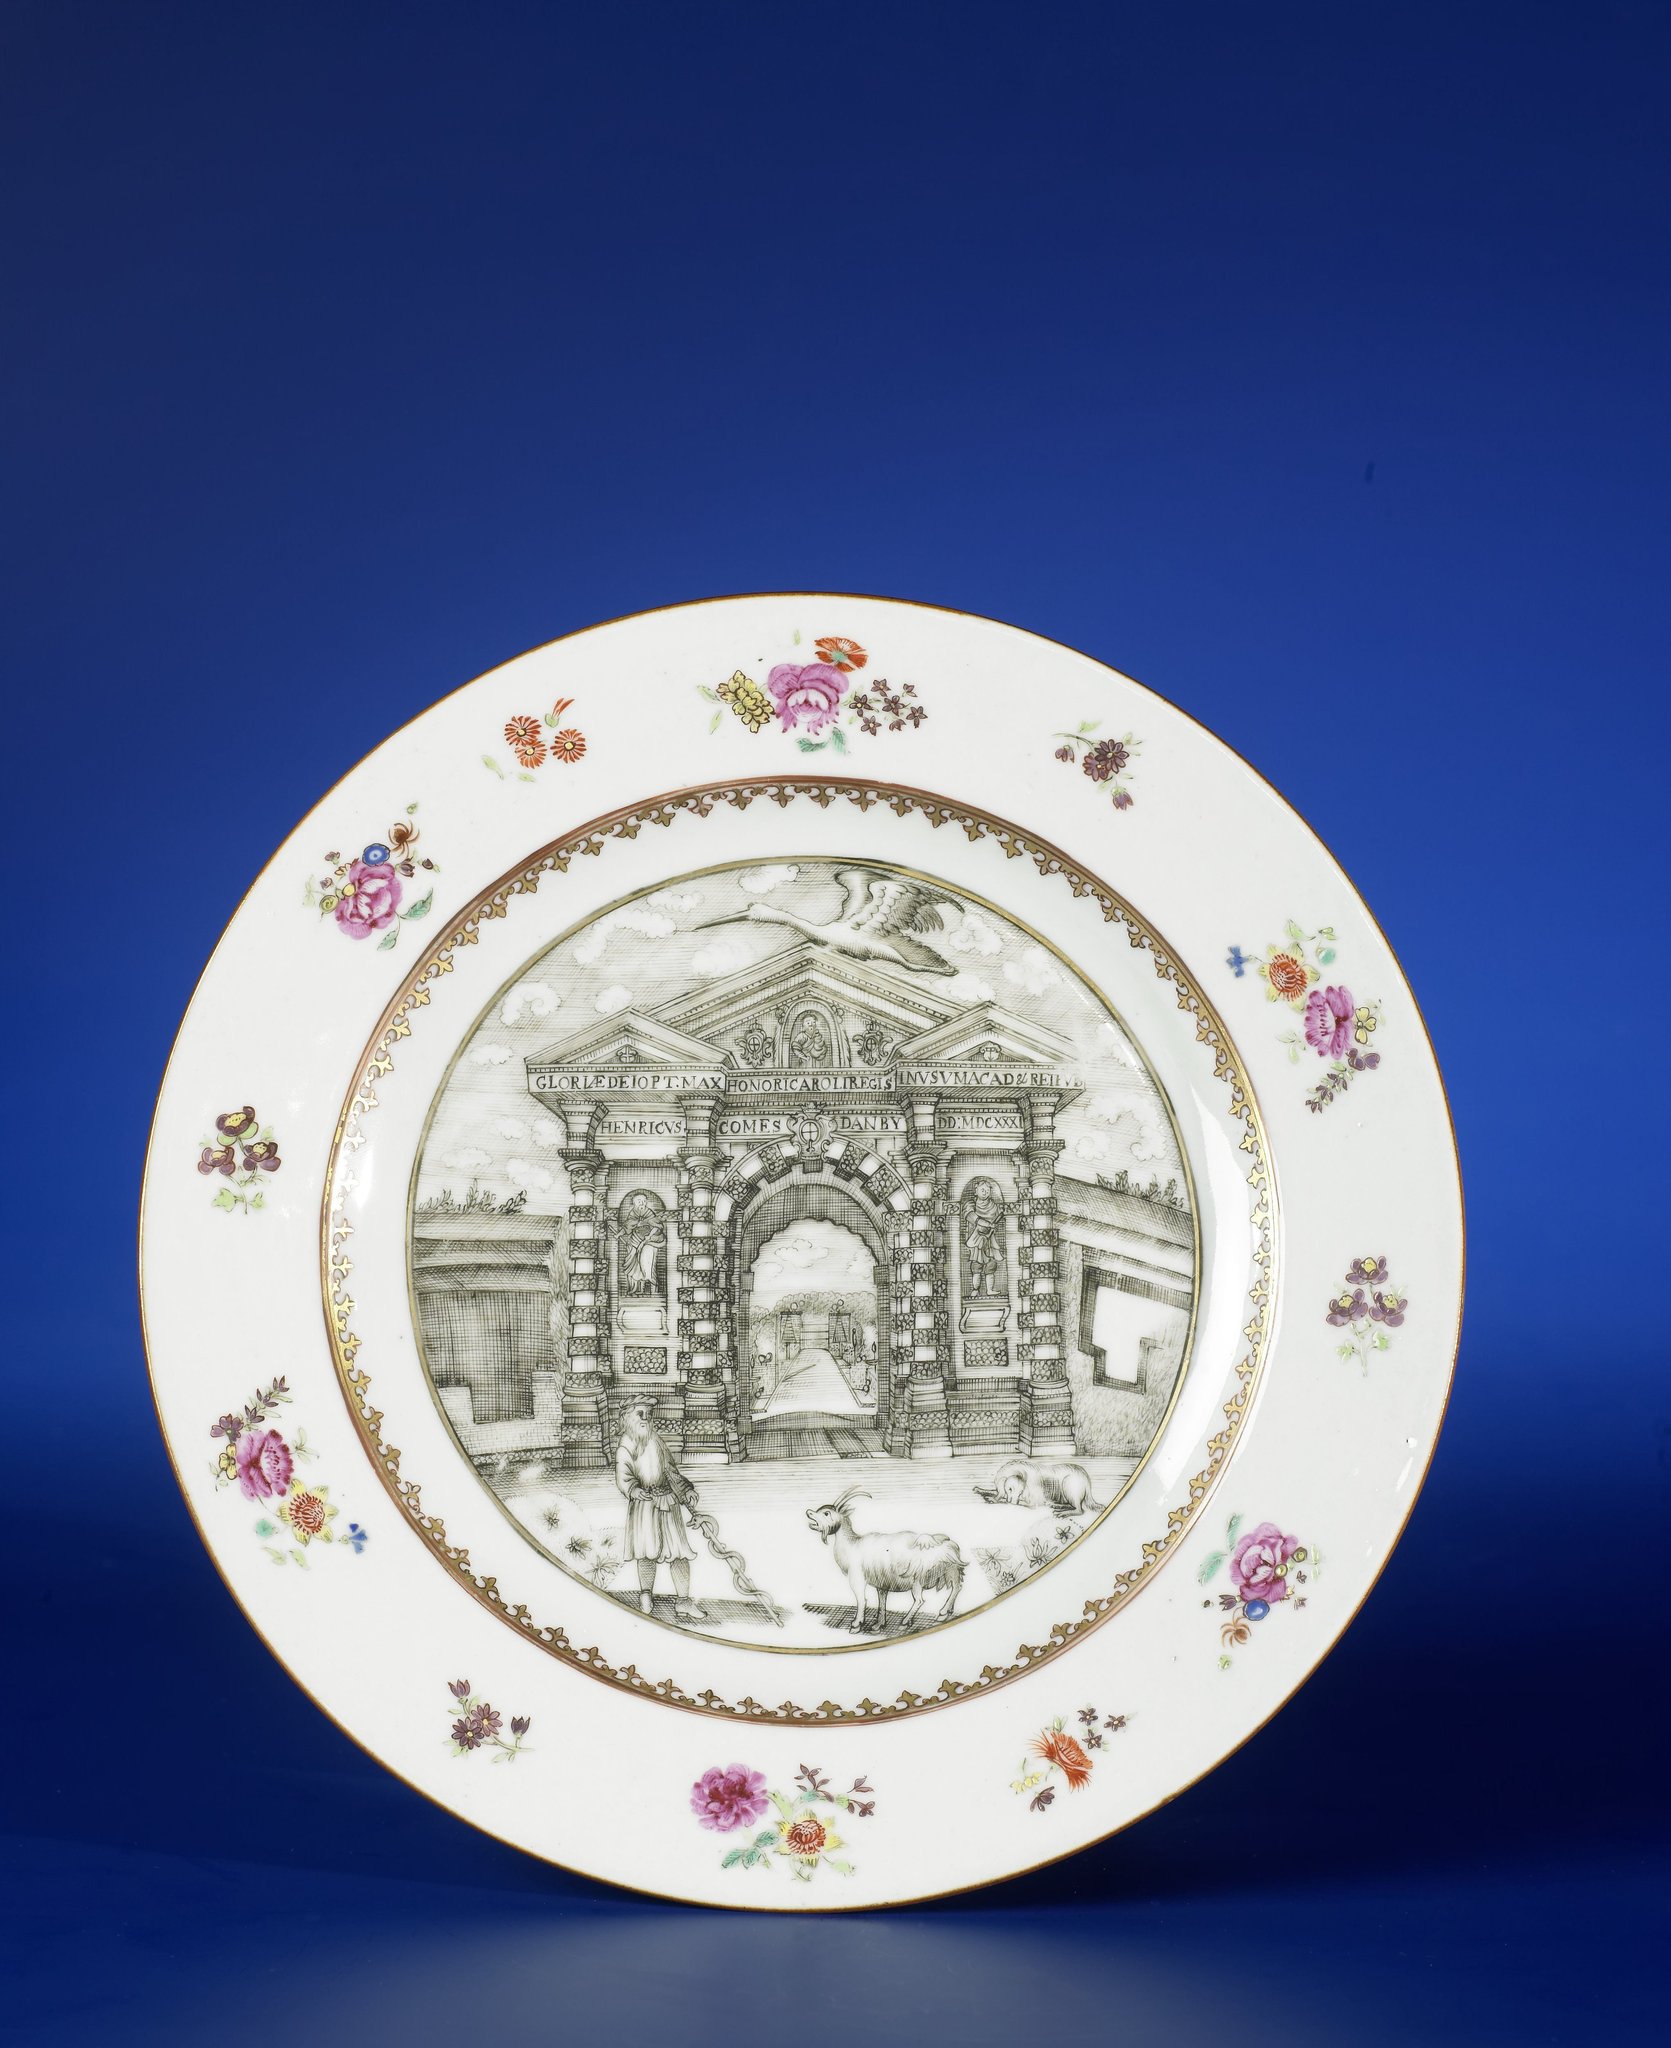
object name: plate dish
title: Plate with Jacob Bobart in front of the Danby-gate in Oxford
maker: Anonymous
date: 1760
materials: glaze, gold, paint, porcelain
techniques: firing, gilding, turning, vitrification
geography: china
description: Bord op een voetring, gedecoreerd in encre de Chine, emailkleuren en goud. Centraal, binnen een rand, is de poort afgebeeld van de botanische tuin in Oxford, Engeland. Daaromheen een fleur de lys-rand, op de rand afwisselend grote en kleine plukken bloemen. De Danby-poort, zoals de poort wordt genoemd, werd in 1632 gebouwd. De prent die als voorbeeld diende wordt toegeschreven aan Michael Burghers (1653?-1727). De prent werd in 1713 gepubliceerd en diende als titelprent voor een gedicht van Abel Evans met de titel 'Vertumnus, An Epistle to Mr. Jacob Bobart, Botany Professor to the University of Oxford, and Keeper of the Physick-Garden'. Op de voorgrond is Bobart (1596-1680) te zien, een Duitse botanist en beheerder van de tuin. De geit zou hem hebben vergezeld bij zijn dagelijkse wandelingen.